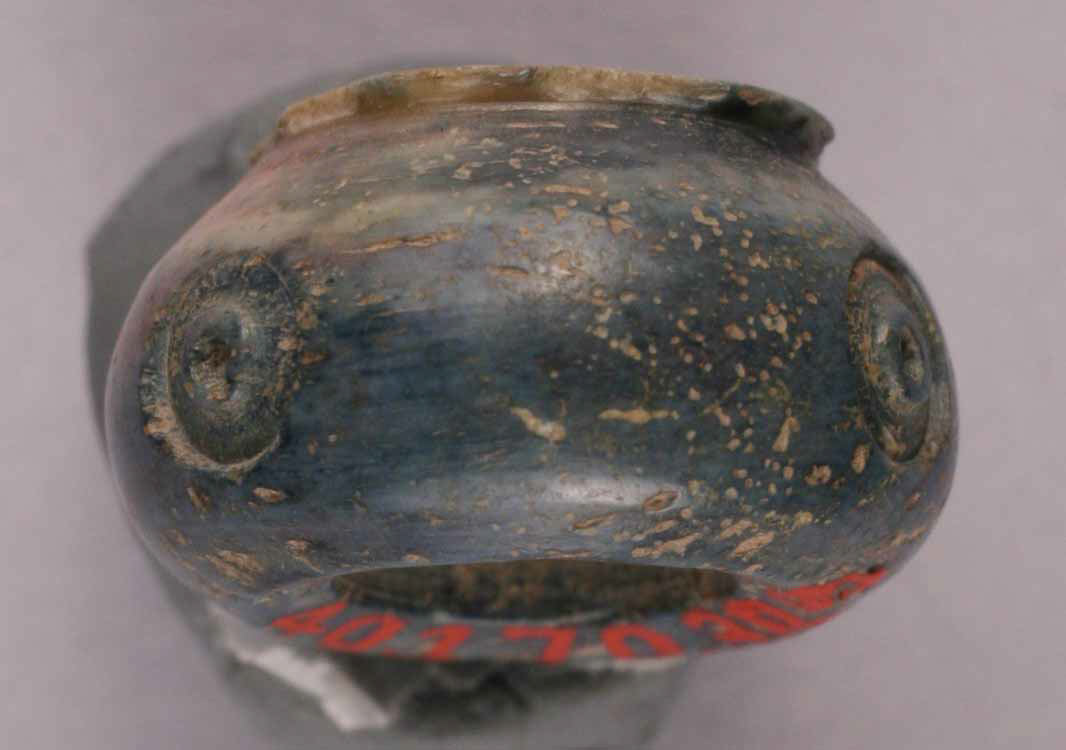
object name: button or bead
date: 801-1000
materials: bone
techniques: incising, tinting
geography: iran